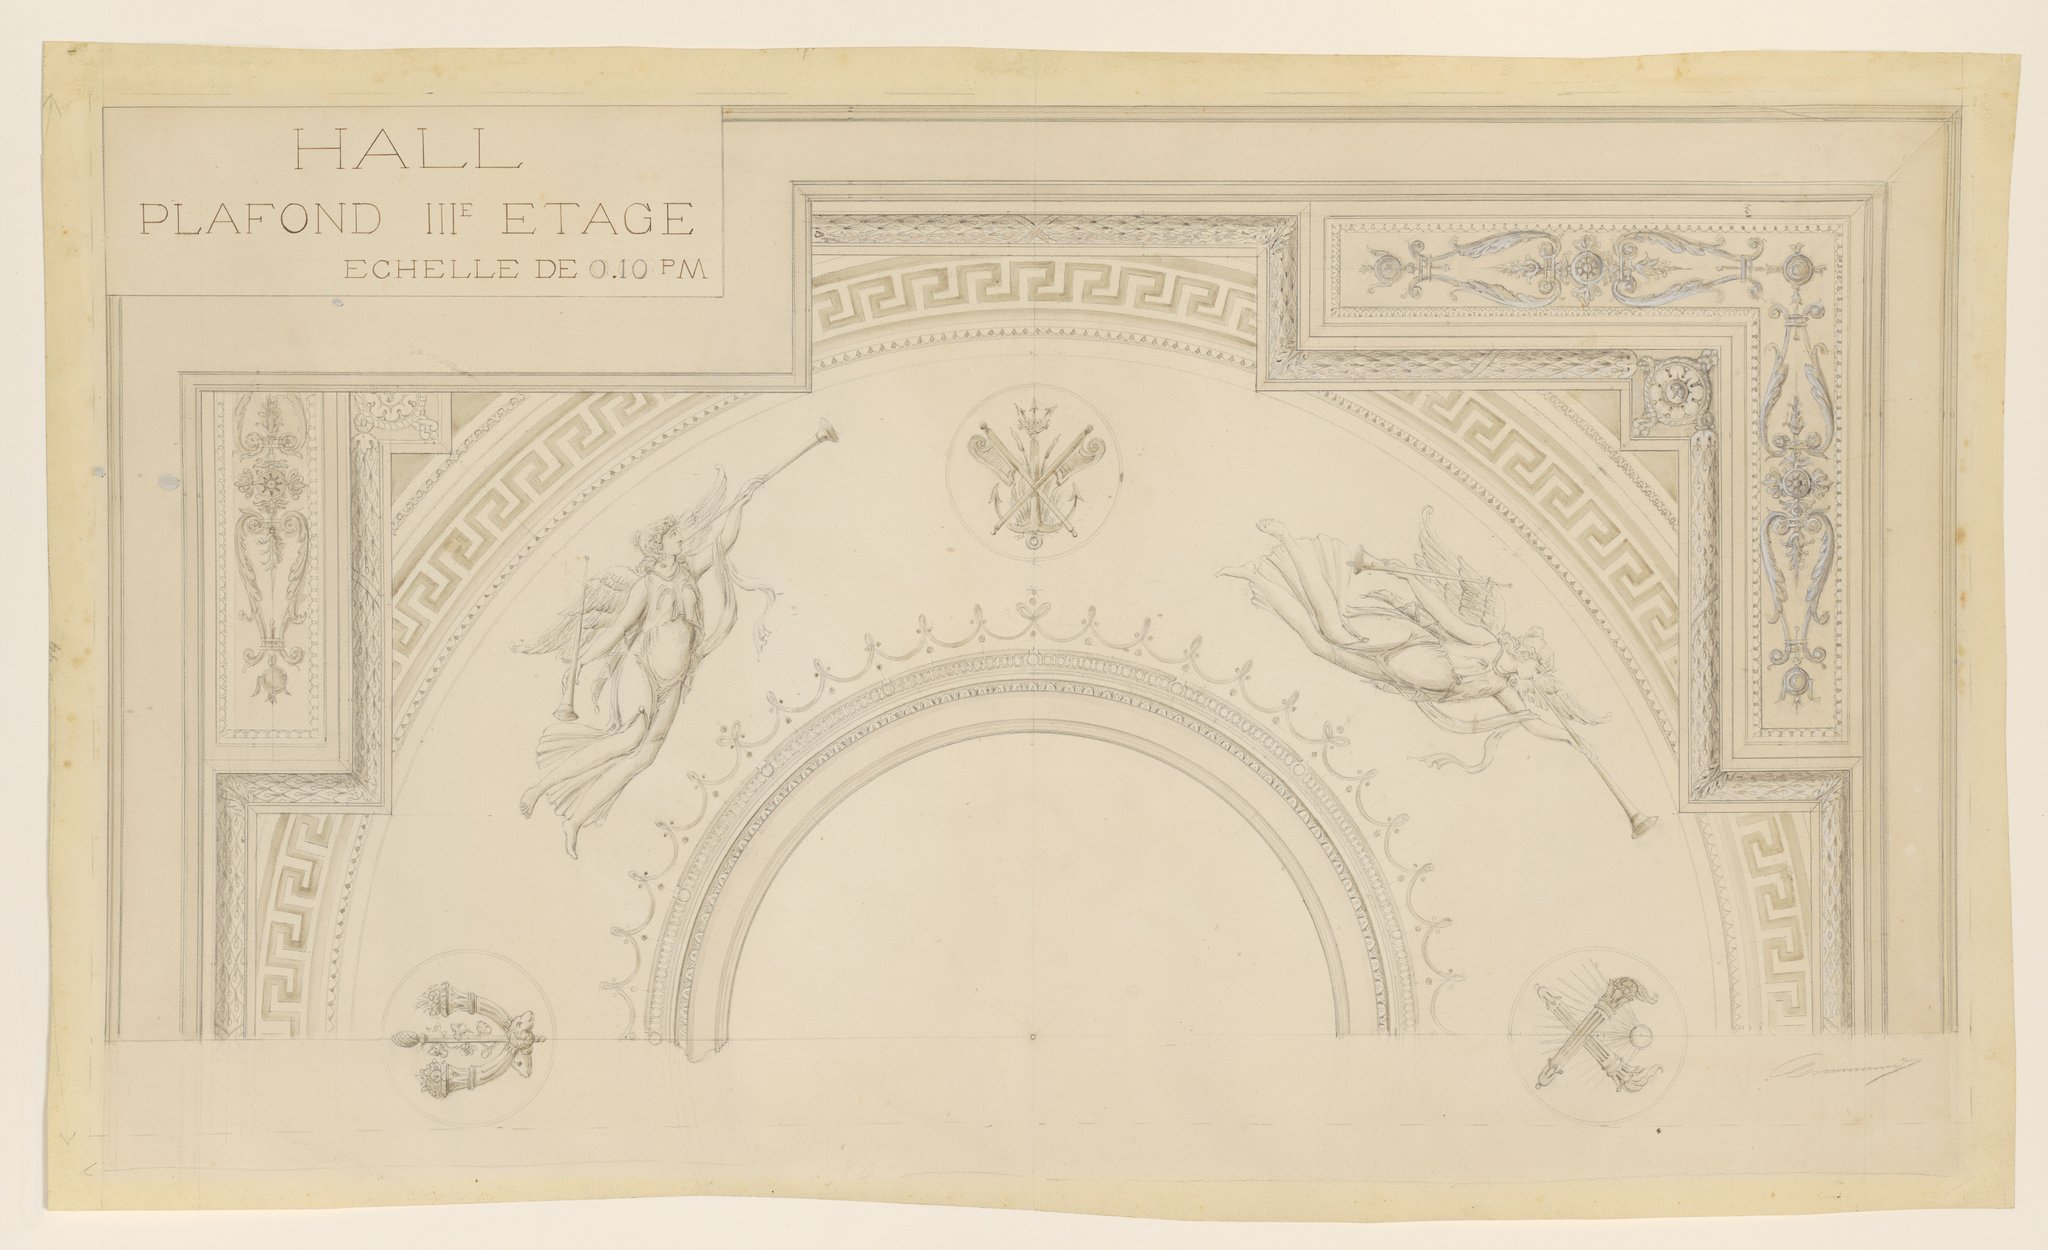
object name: drawing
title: Design for the Ceiling of the Center Hall of Château de Syam, France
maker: anonymous, french, 19th century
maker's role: artist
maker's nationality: french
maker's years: 1800-1900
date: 1820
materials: graphite, ink, watercolor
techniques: pen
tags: architecture,ceilings